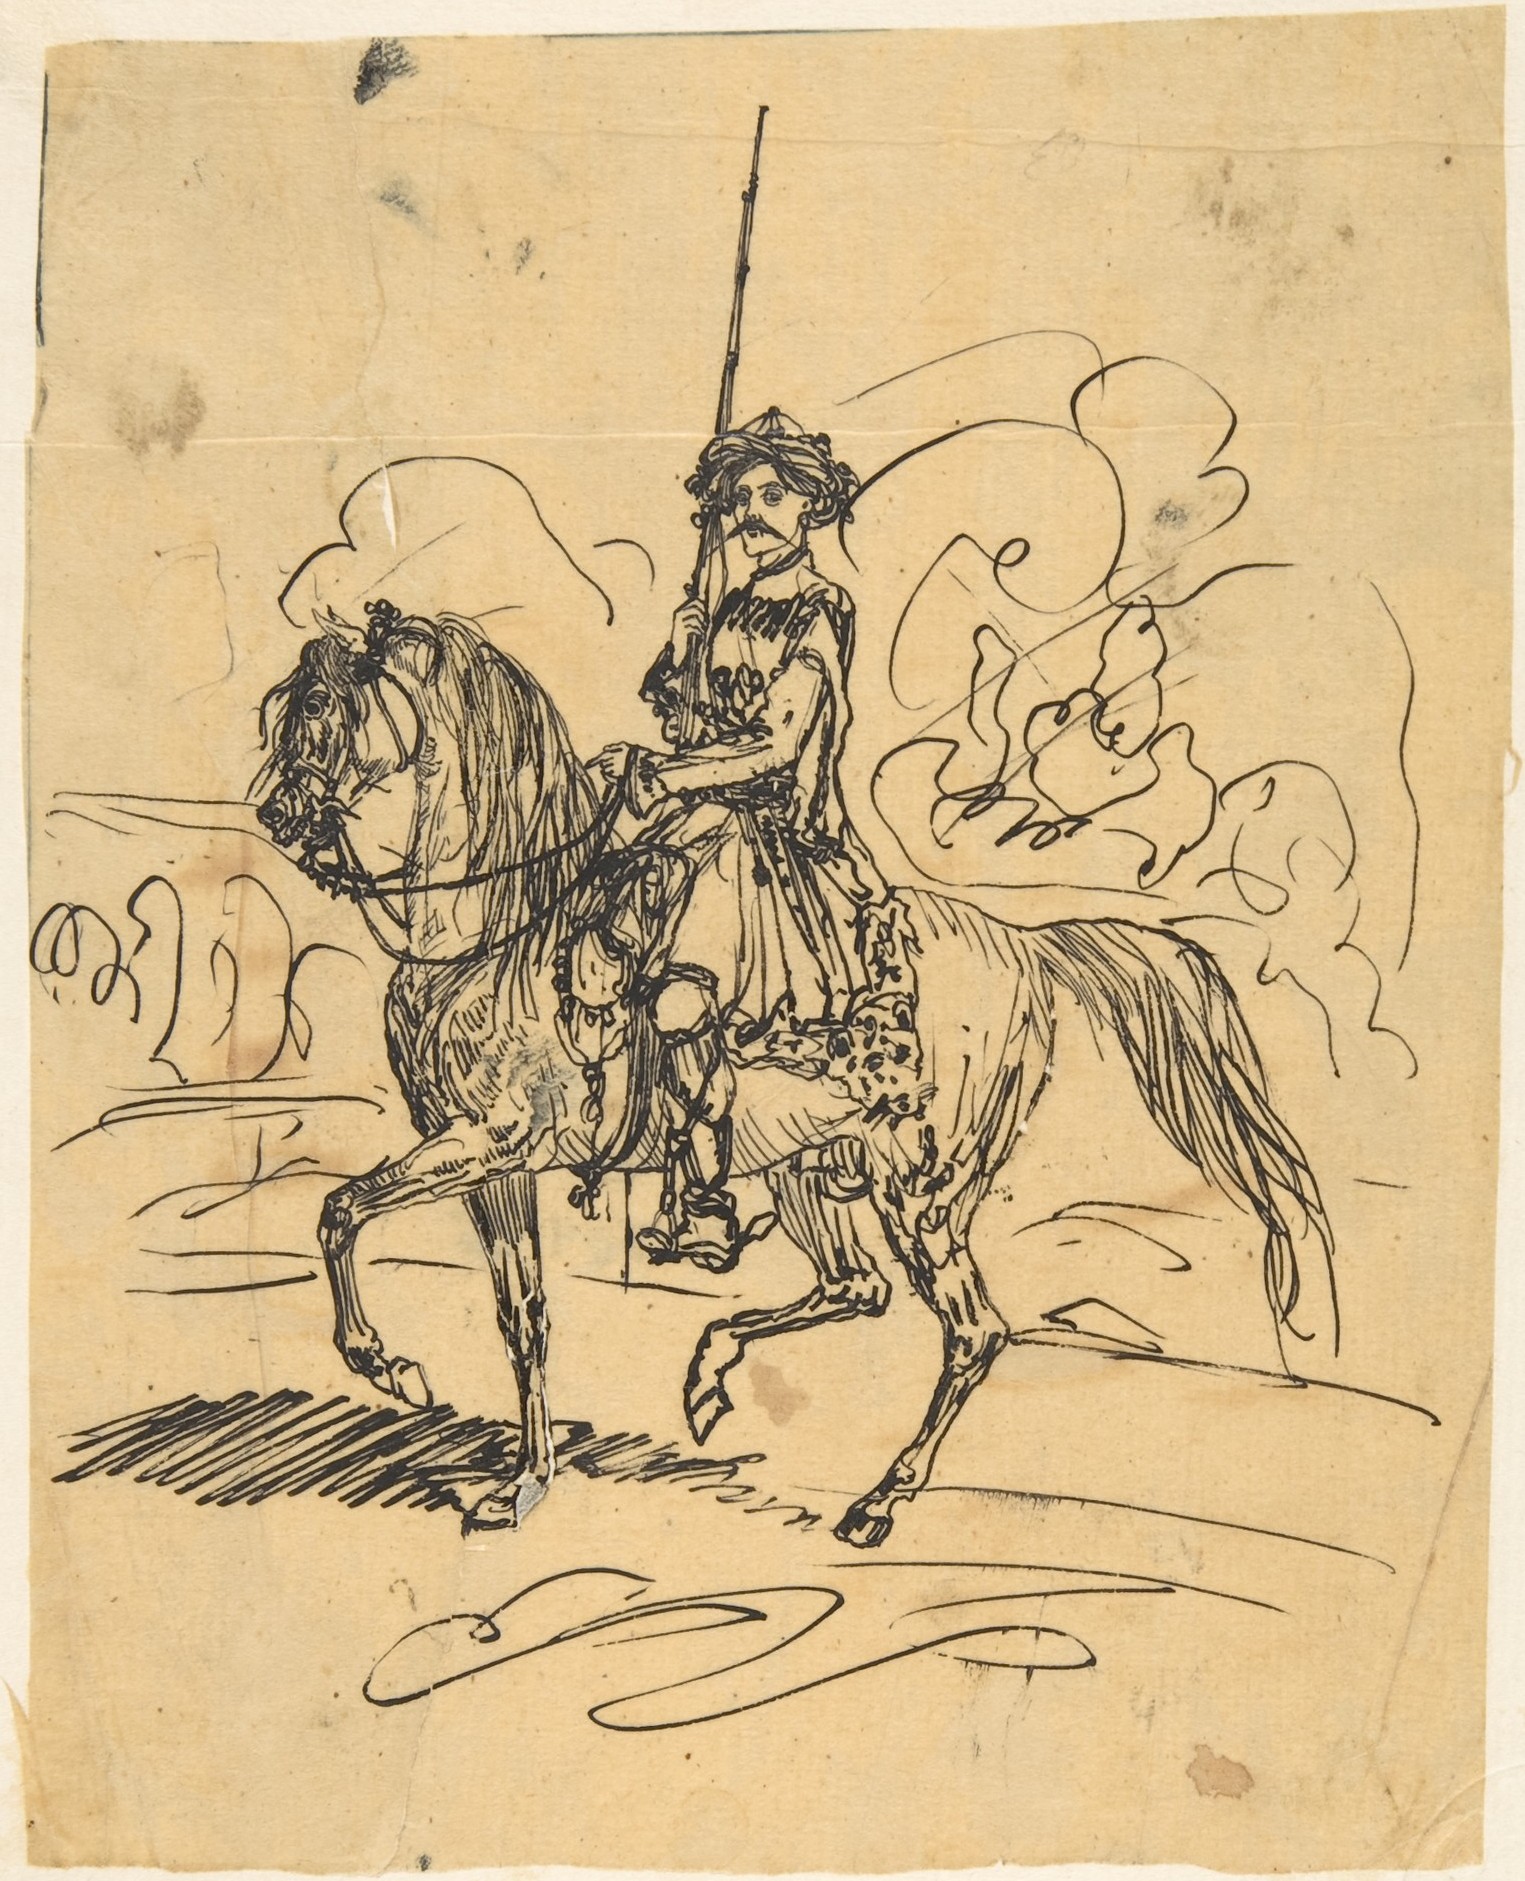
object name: drawing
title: Oriental Rider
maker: rodolphe bresdin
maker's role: artist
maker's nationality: french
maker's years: 1822-1885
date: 1822-1885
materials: ink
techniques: pen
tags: firearms,men,horses